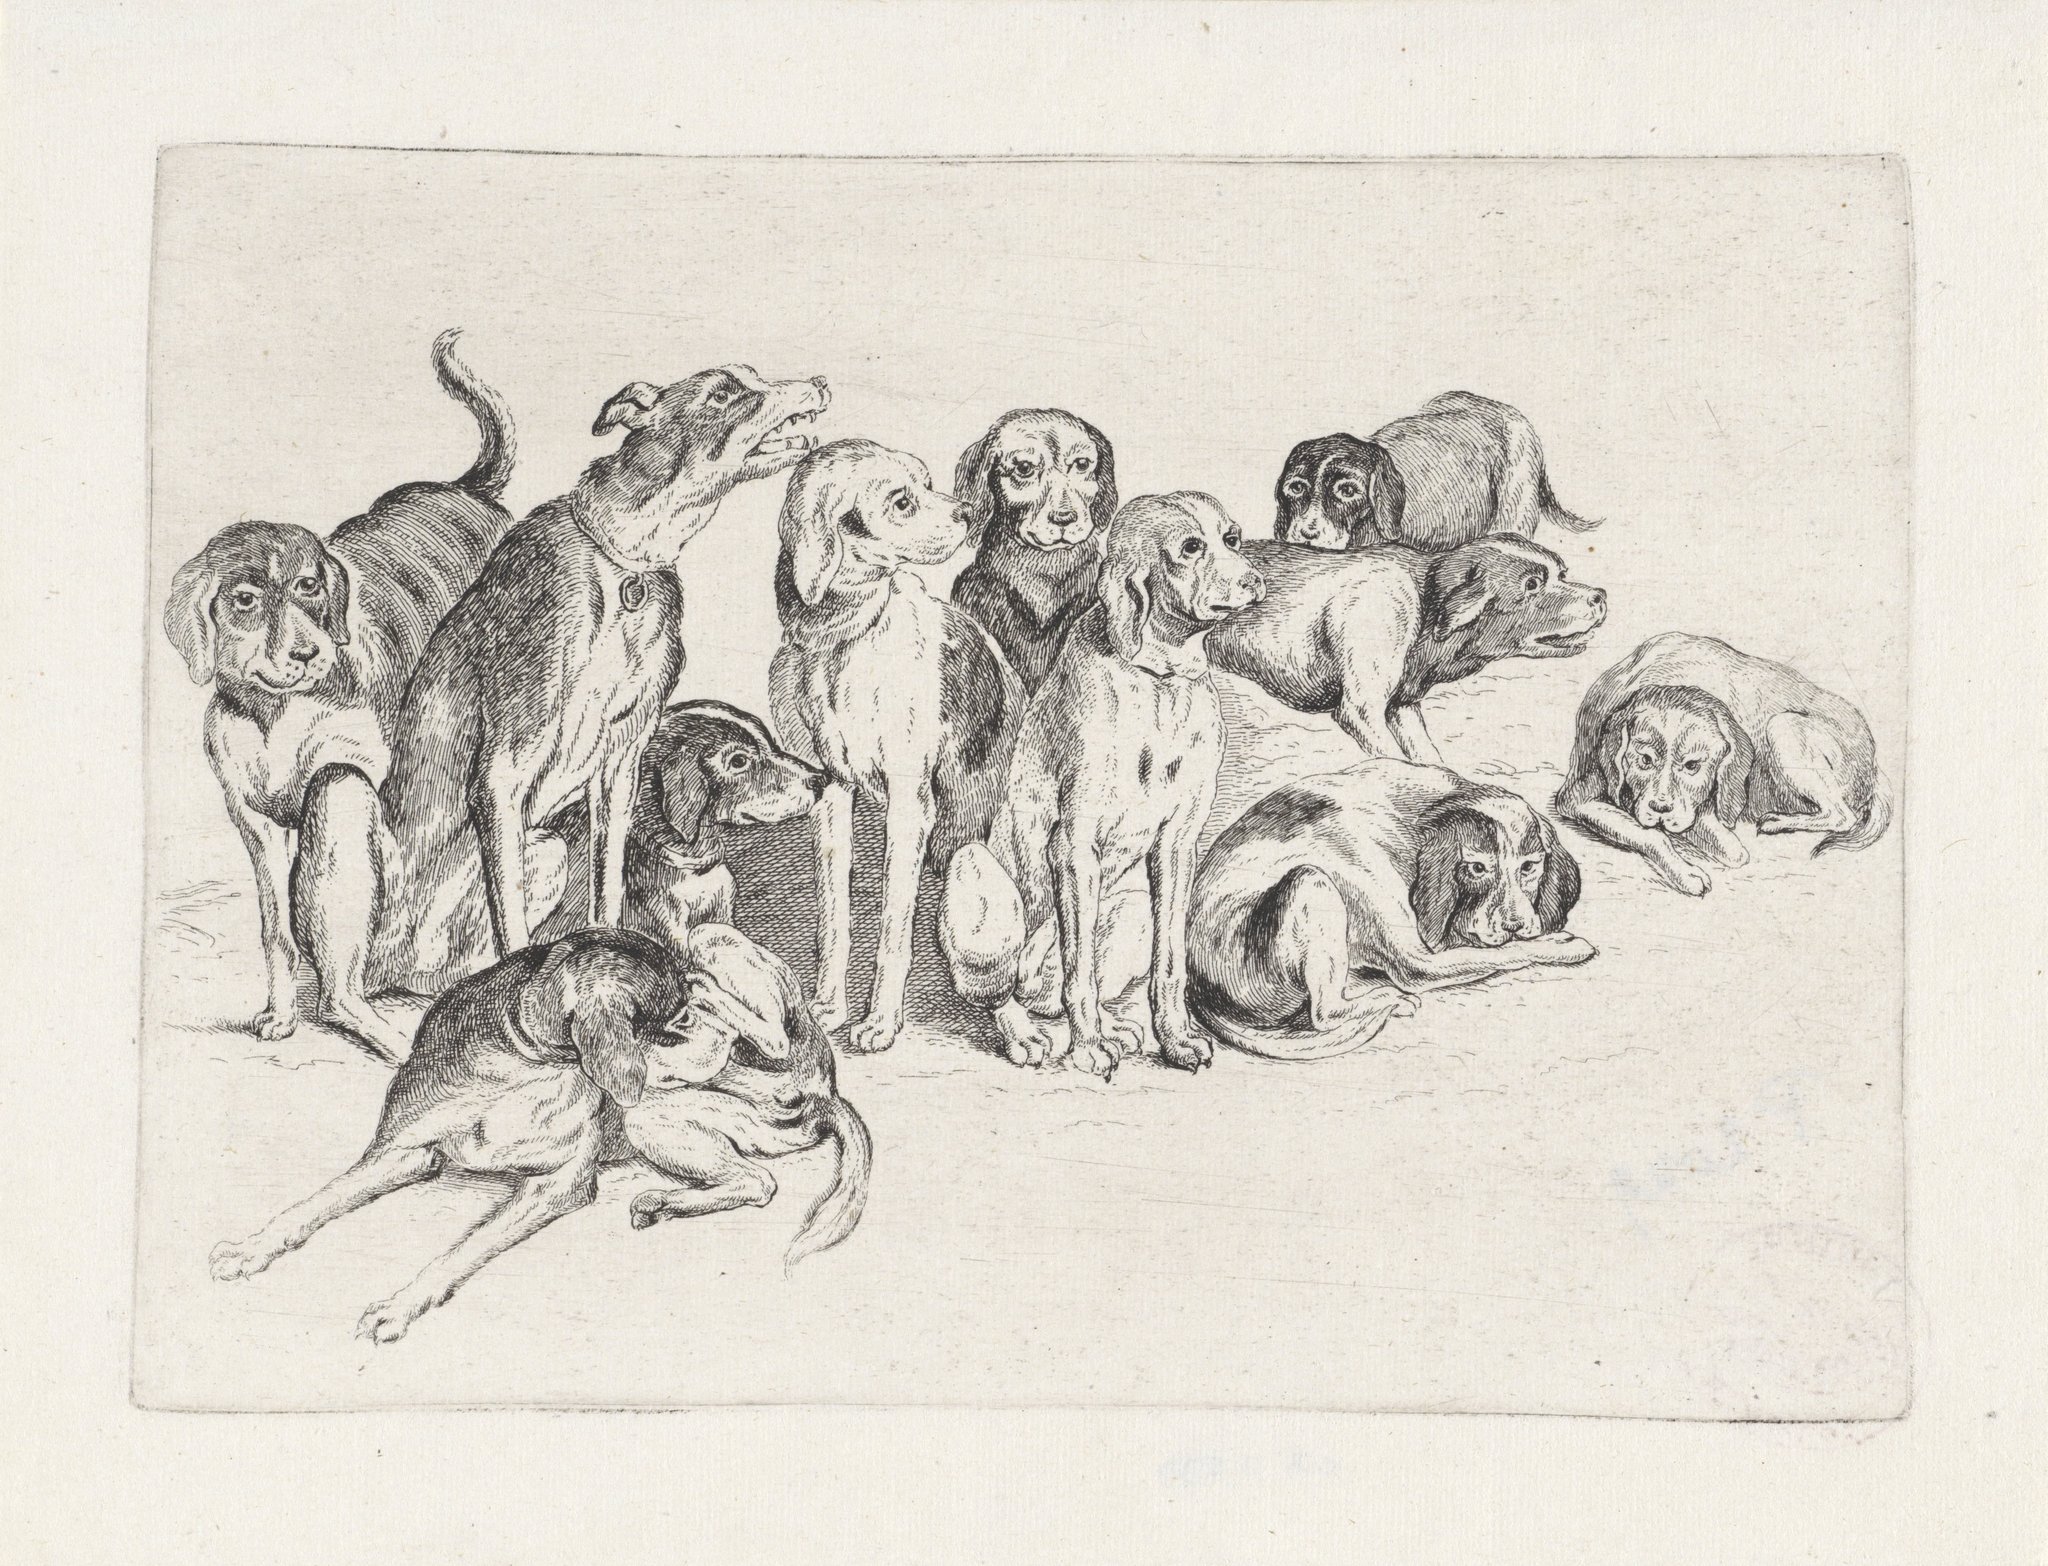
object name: print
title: Elf jachthonden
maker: wenceslaus hollar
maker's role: draughtsman, print maker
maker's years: 1607-1677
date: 1646-1647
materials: paper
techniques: etching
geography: antwerp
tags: hunting dogs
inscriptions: collector's mark: Lugt 240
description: Prent uit twintigdelige serie (incl. titelprent) met voorstellingen over de jacht: "Jacht, jachthonden en wild".